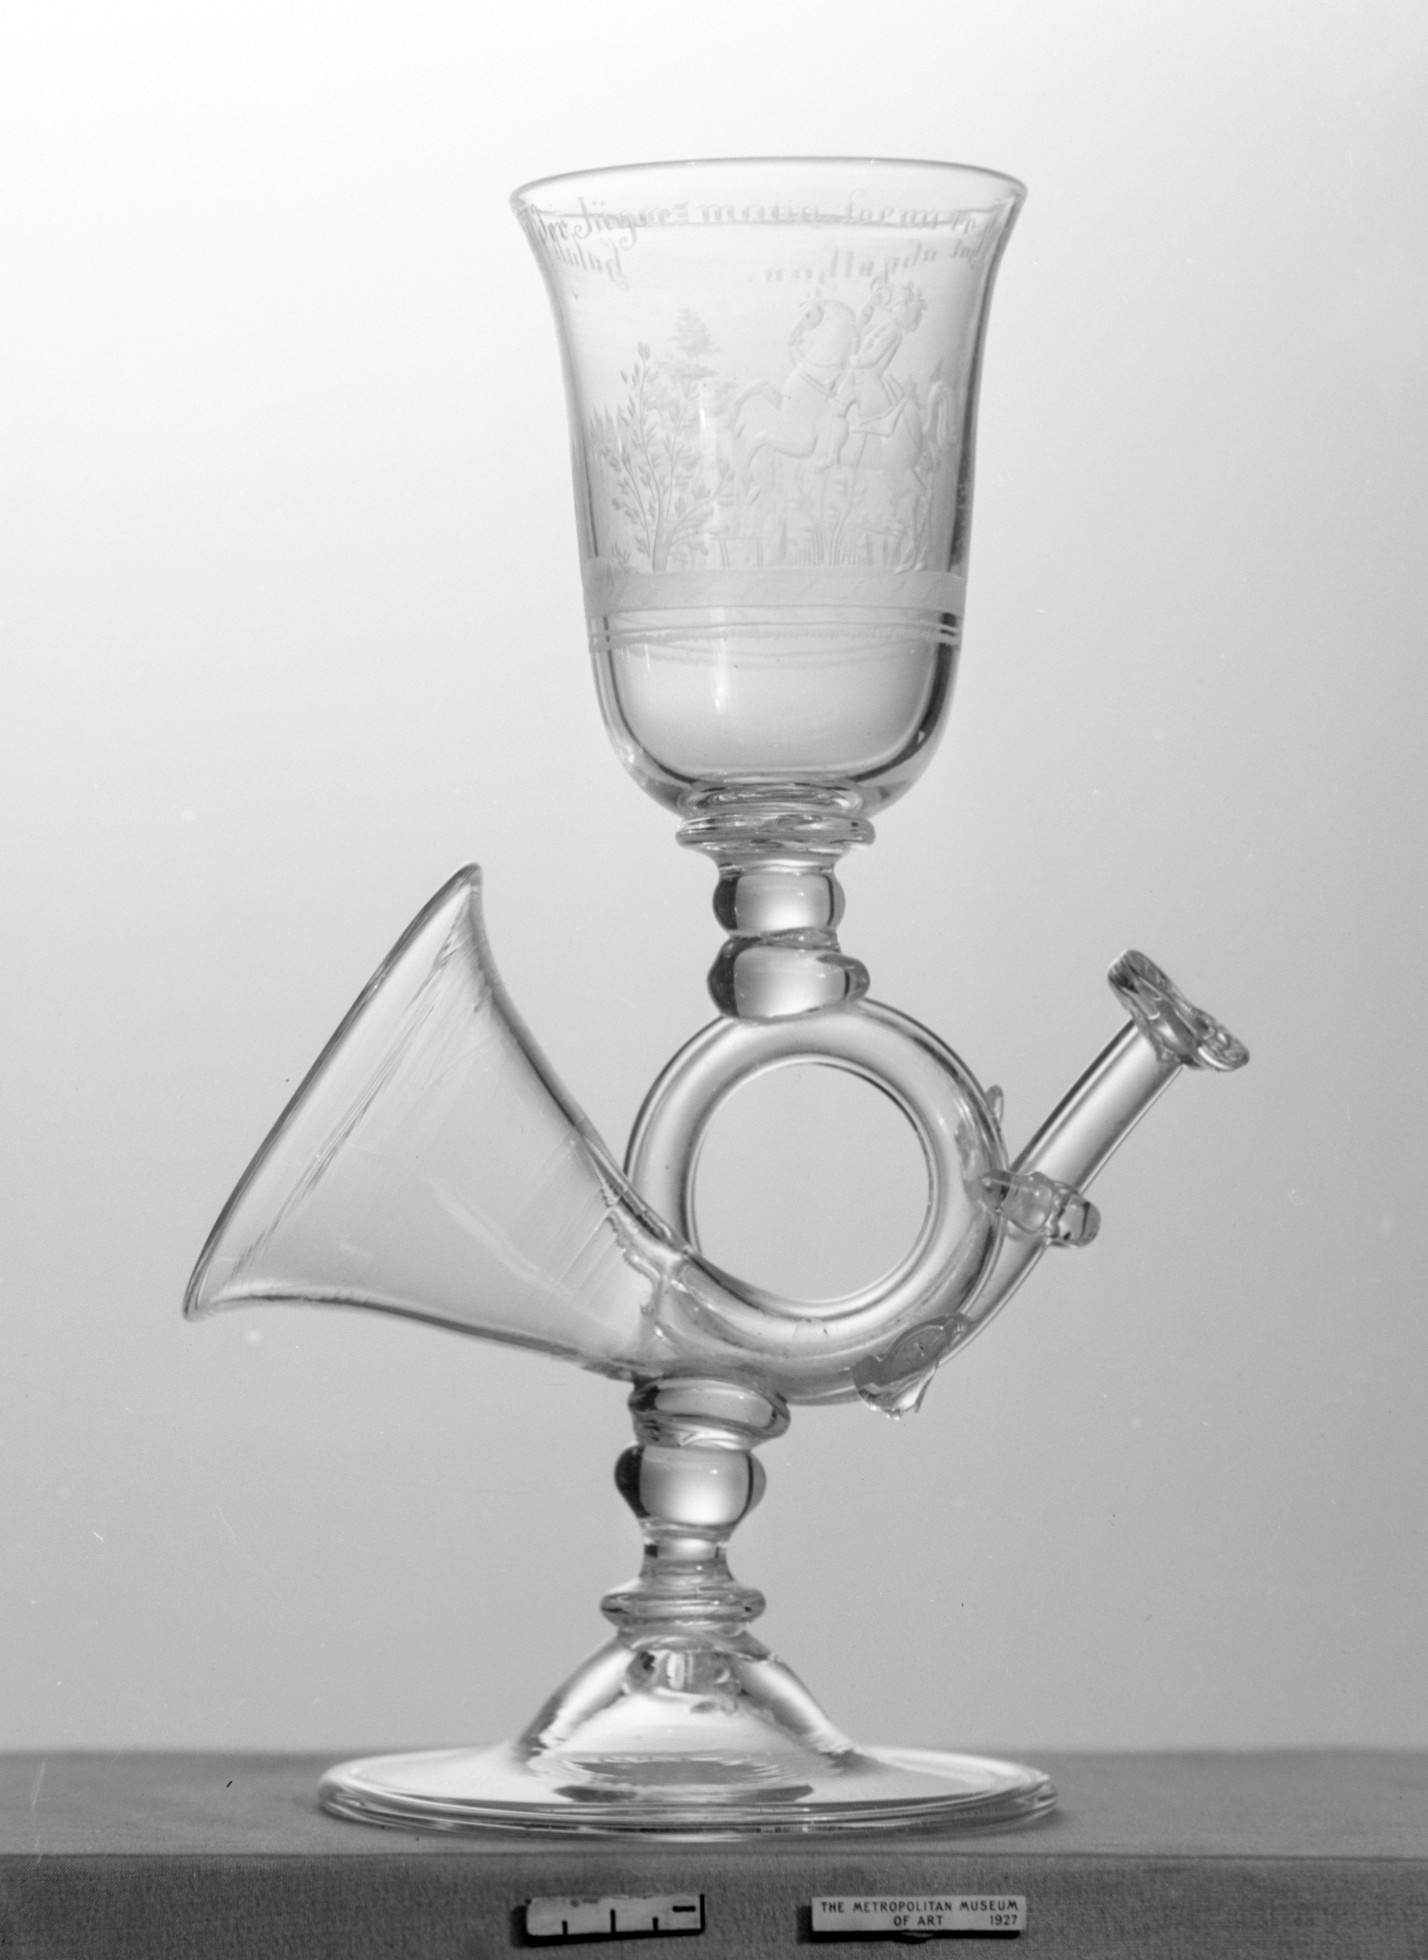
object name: standing cup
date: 1700-1750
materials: glass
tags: trumpets